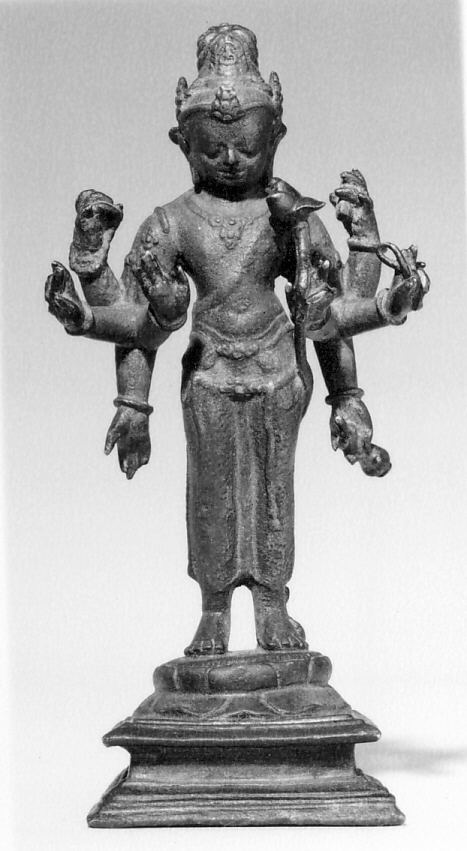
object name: figure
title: Eight-Armed Bodhisattva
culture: indonesian, javanese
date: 801-900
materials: bronze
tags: buddhism,bodhisattvas